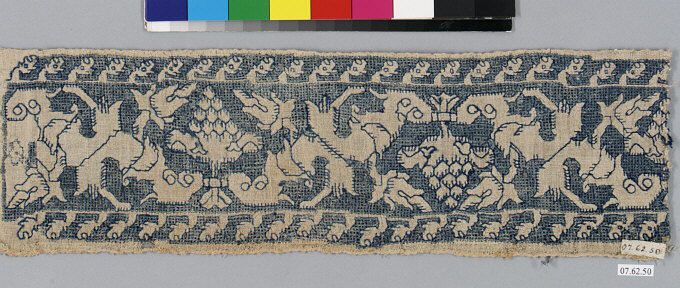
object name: border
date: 1601-1700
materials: linen, silk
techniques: embroidery